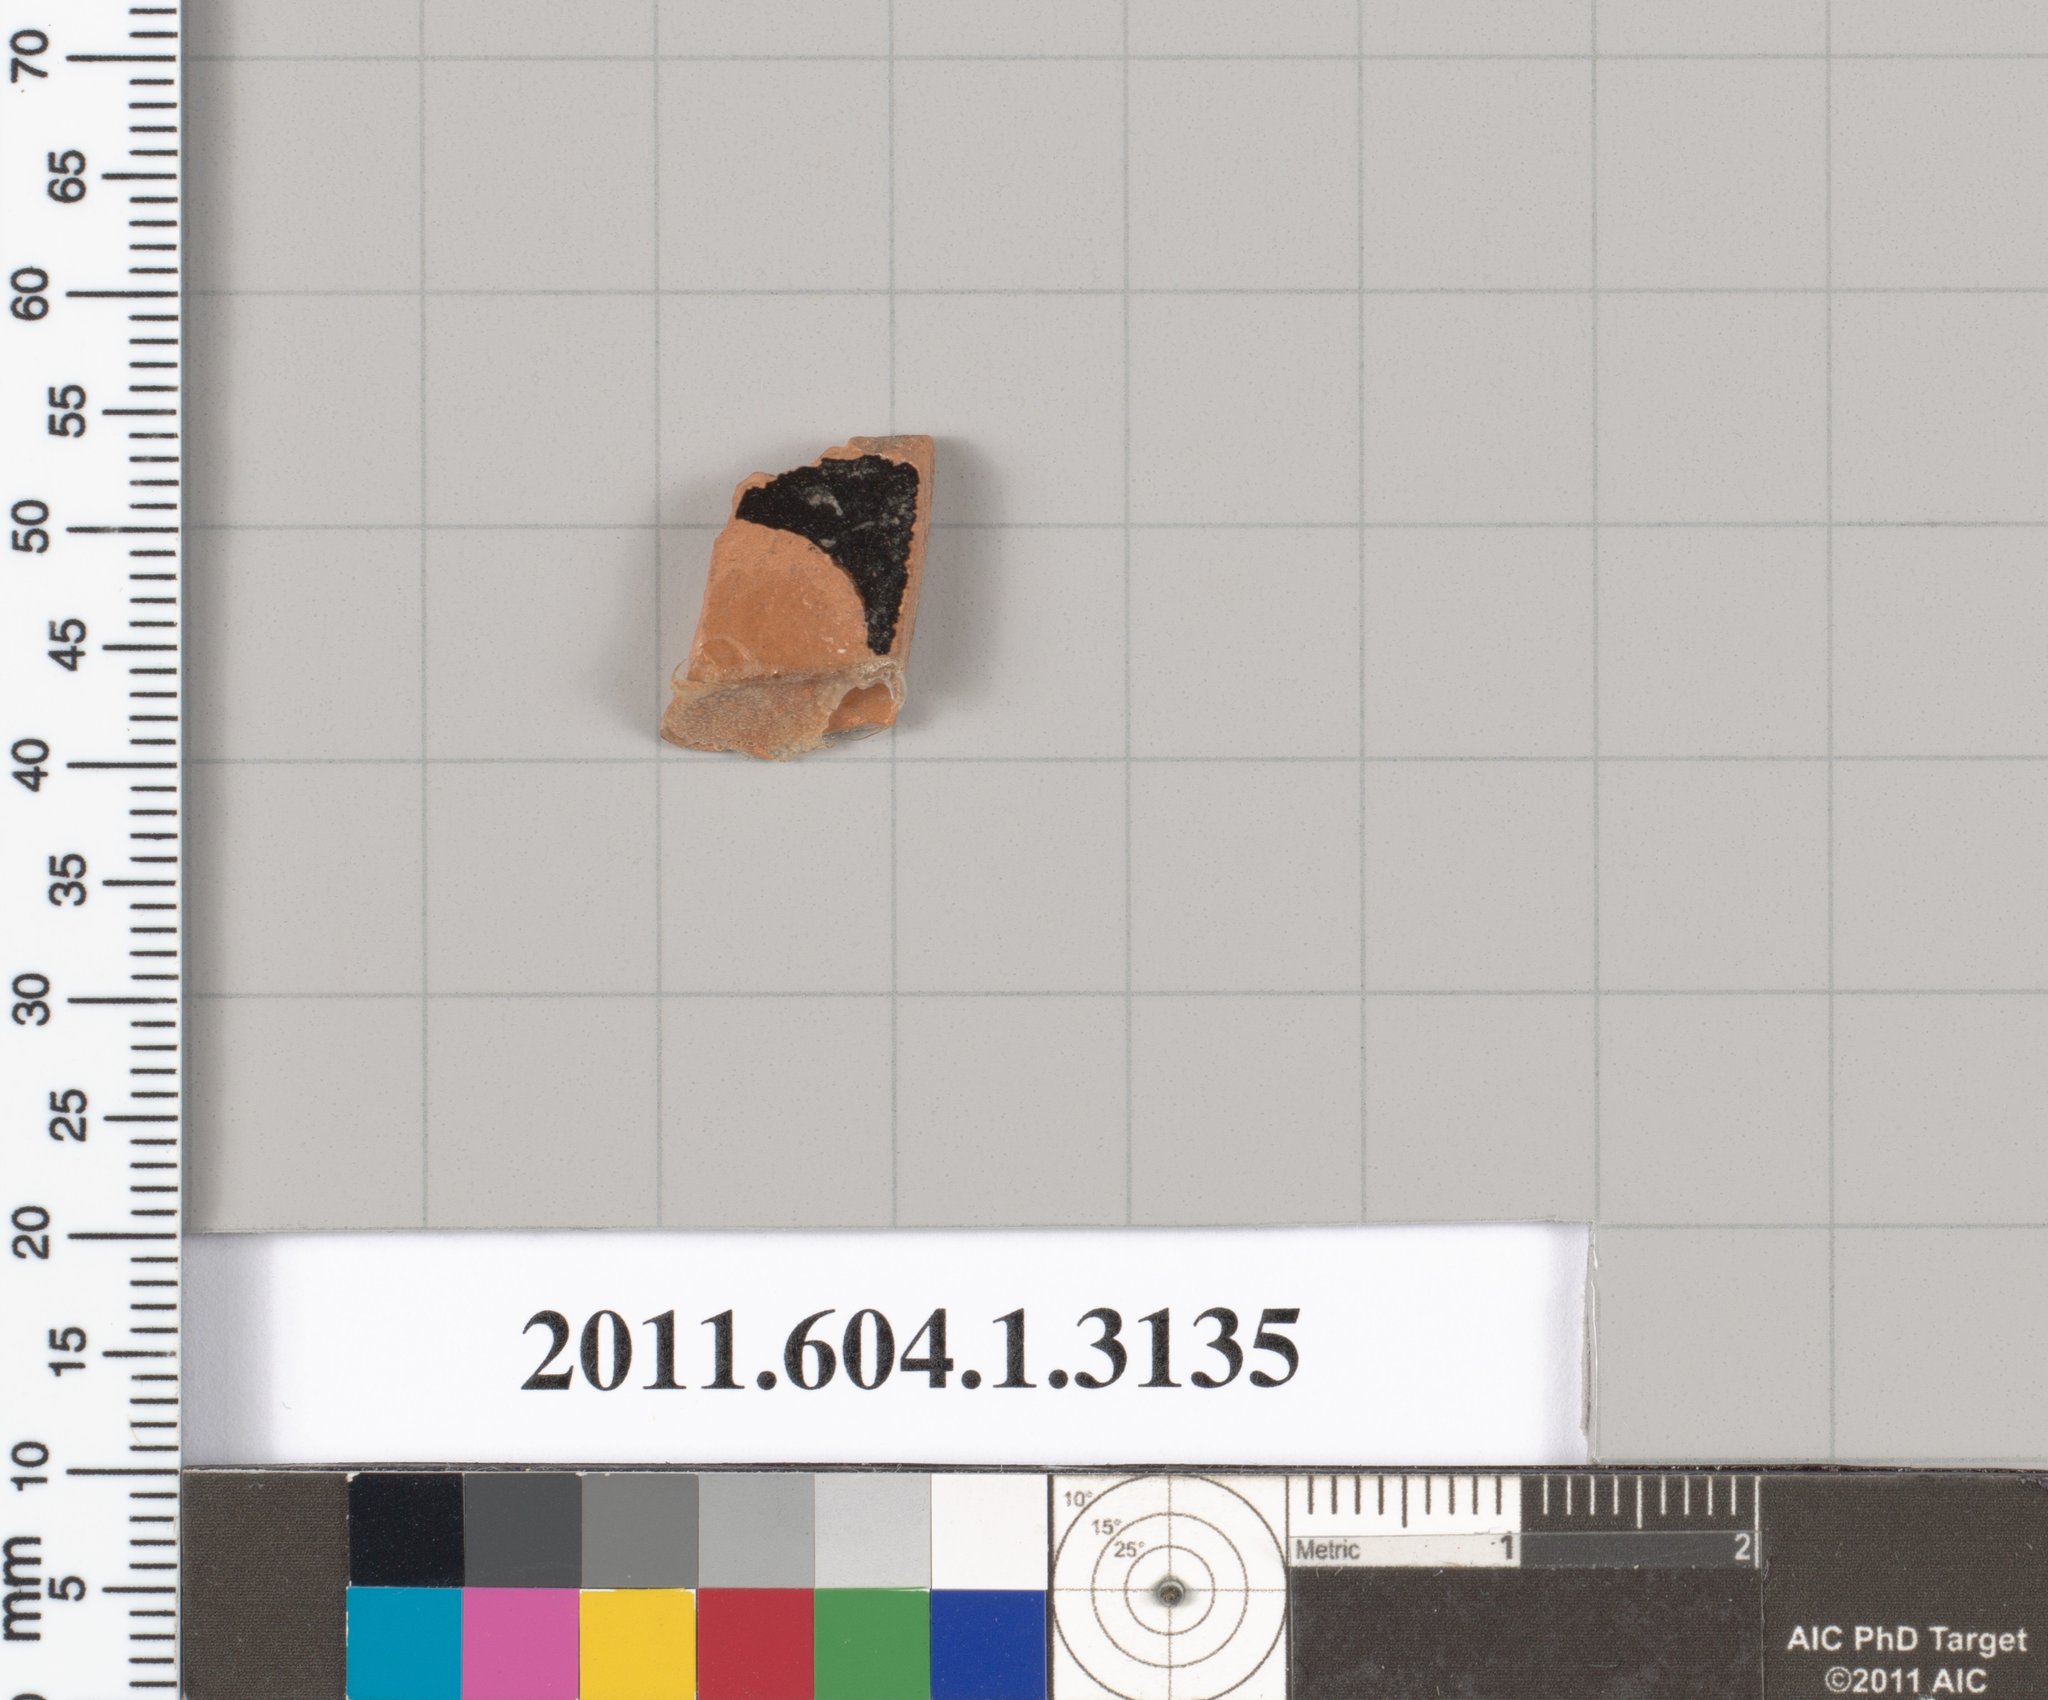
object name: kylix fragment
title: Terracotta fragment of a kylix (drinking cup)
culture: greek, attic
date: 500-451 BCE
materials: terracotta